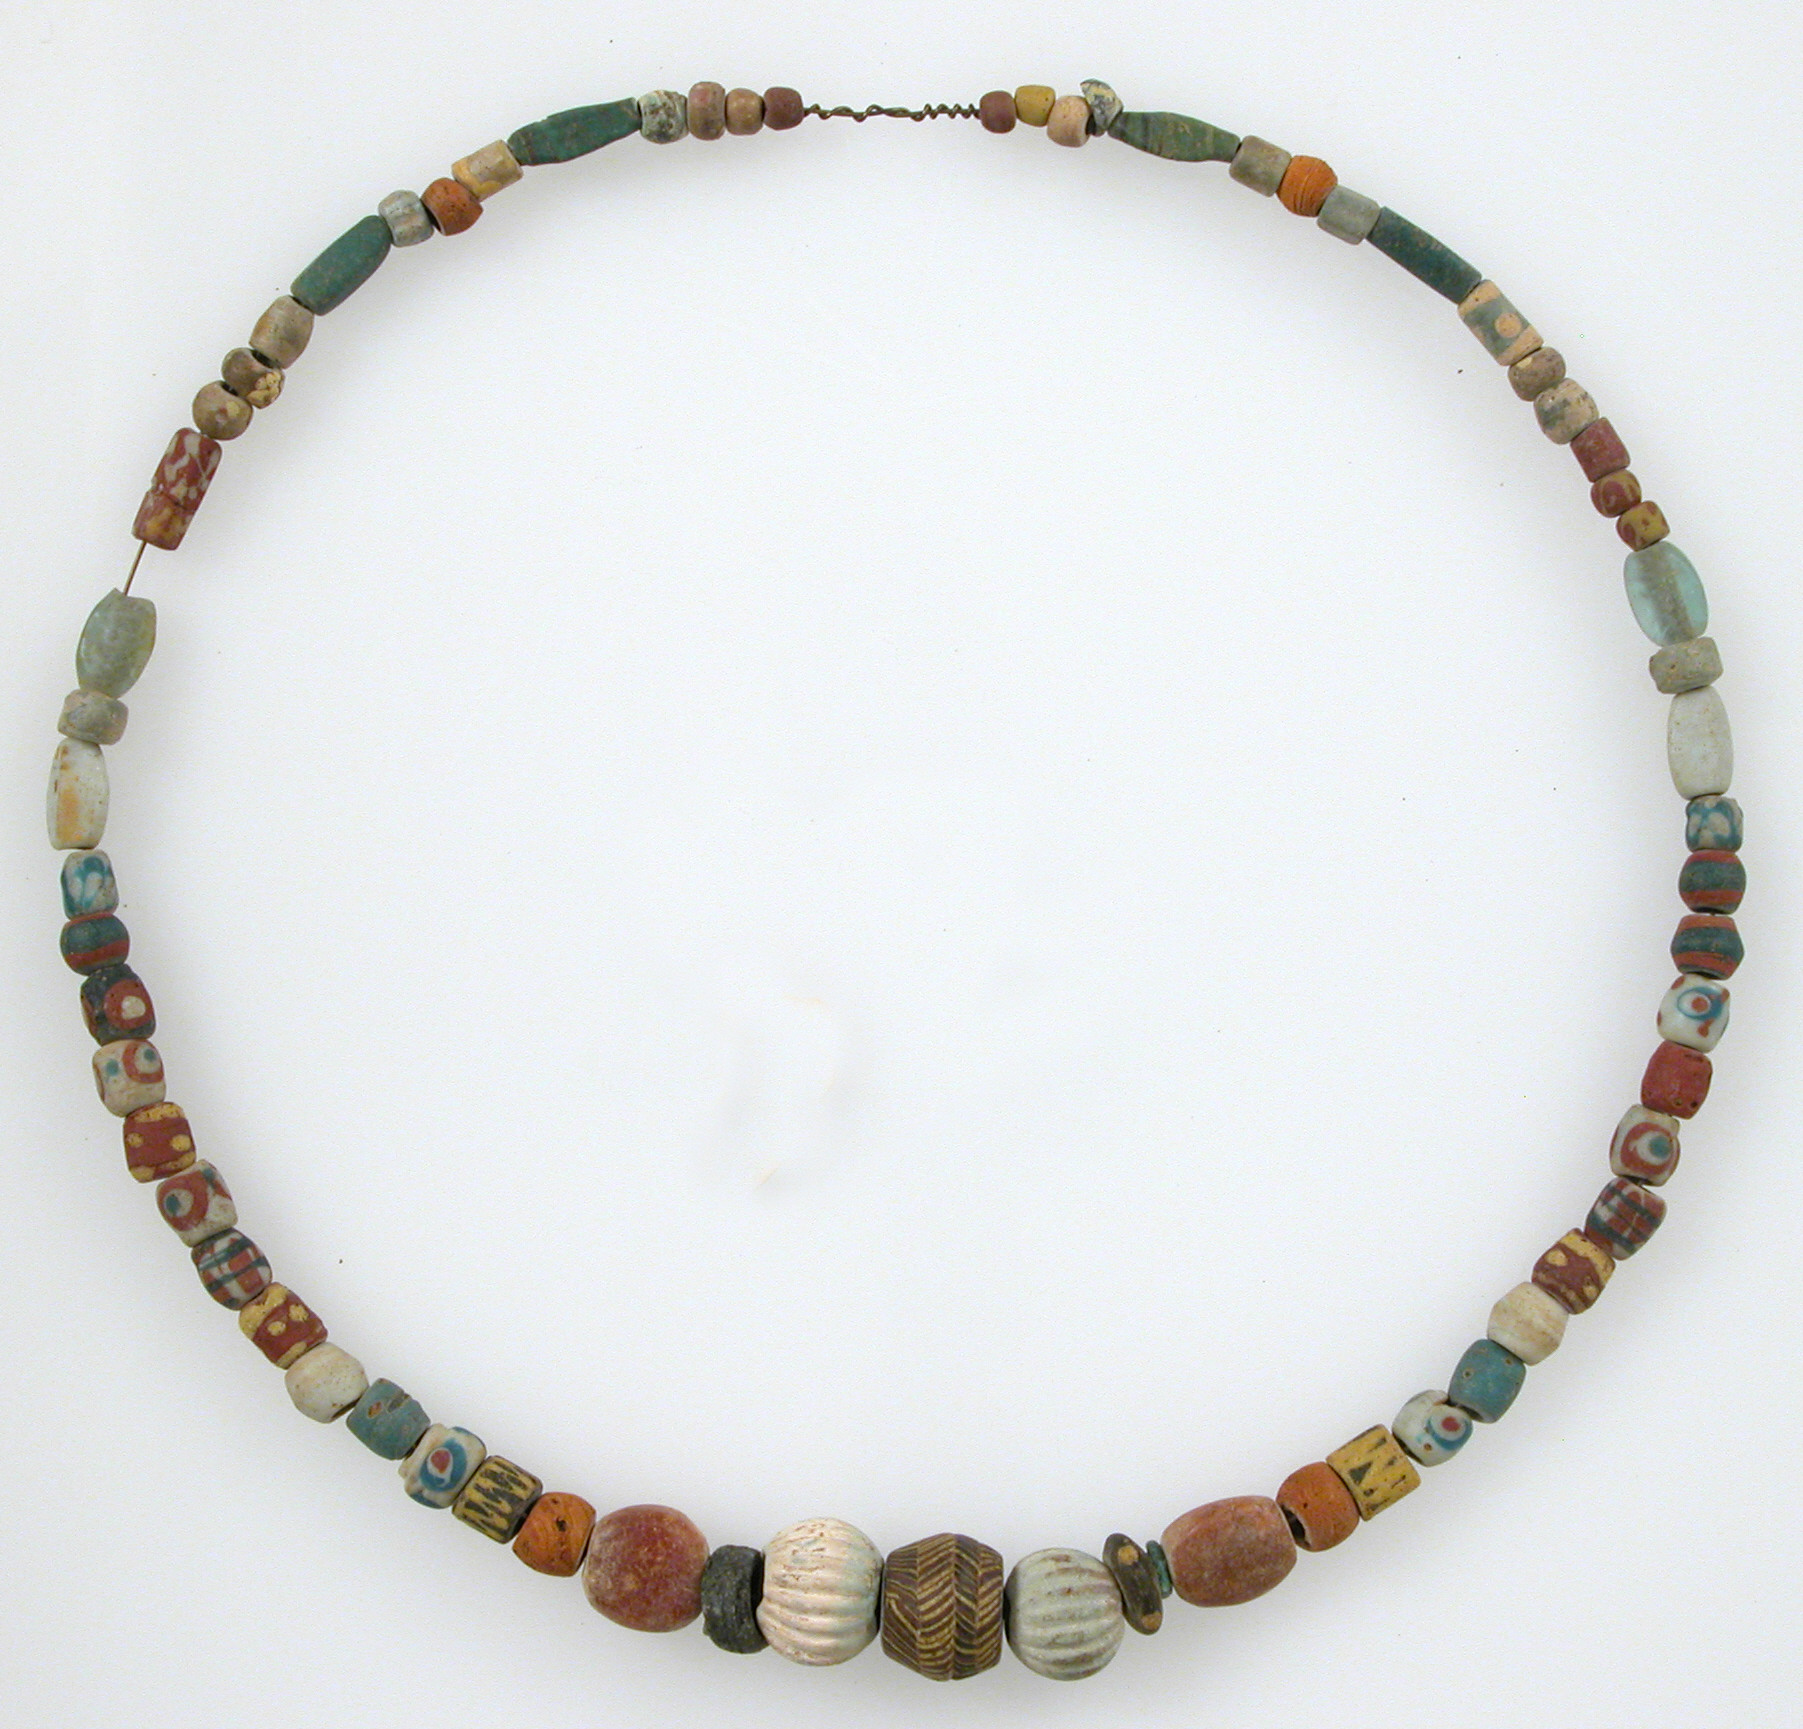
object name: necklace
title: Beaded Necklace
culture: frankish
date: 500-600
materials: amber, copper alloy, earthenware, glass, silver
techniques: glazing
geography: germany